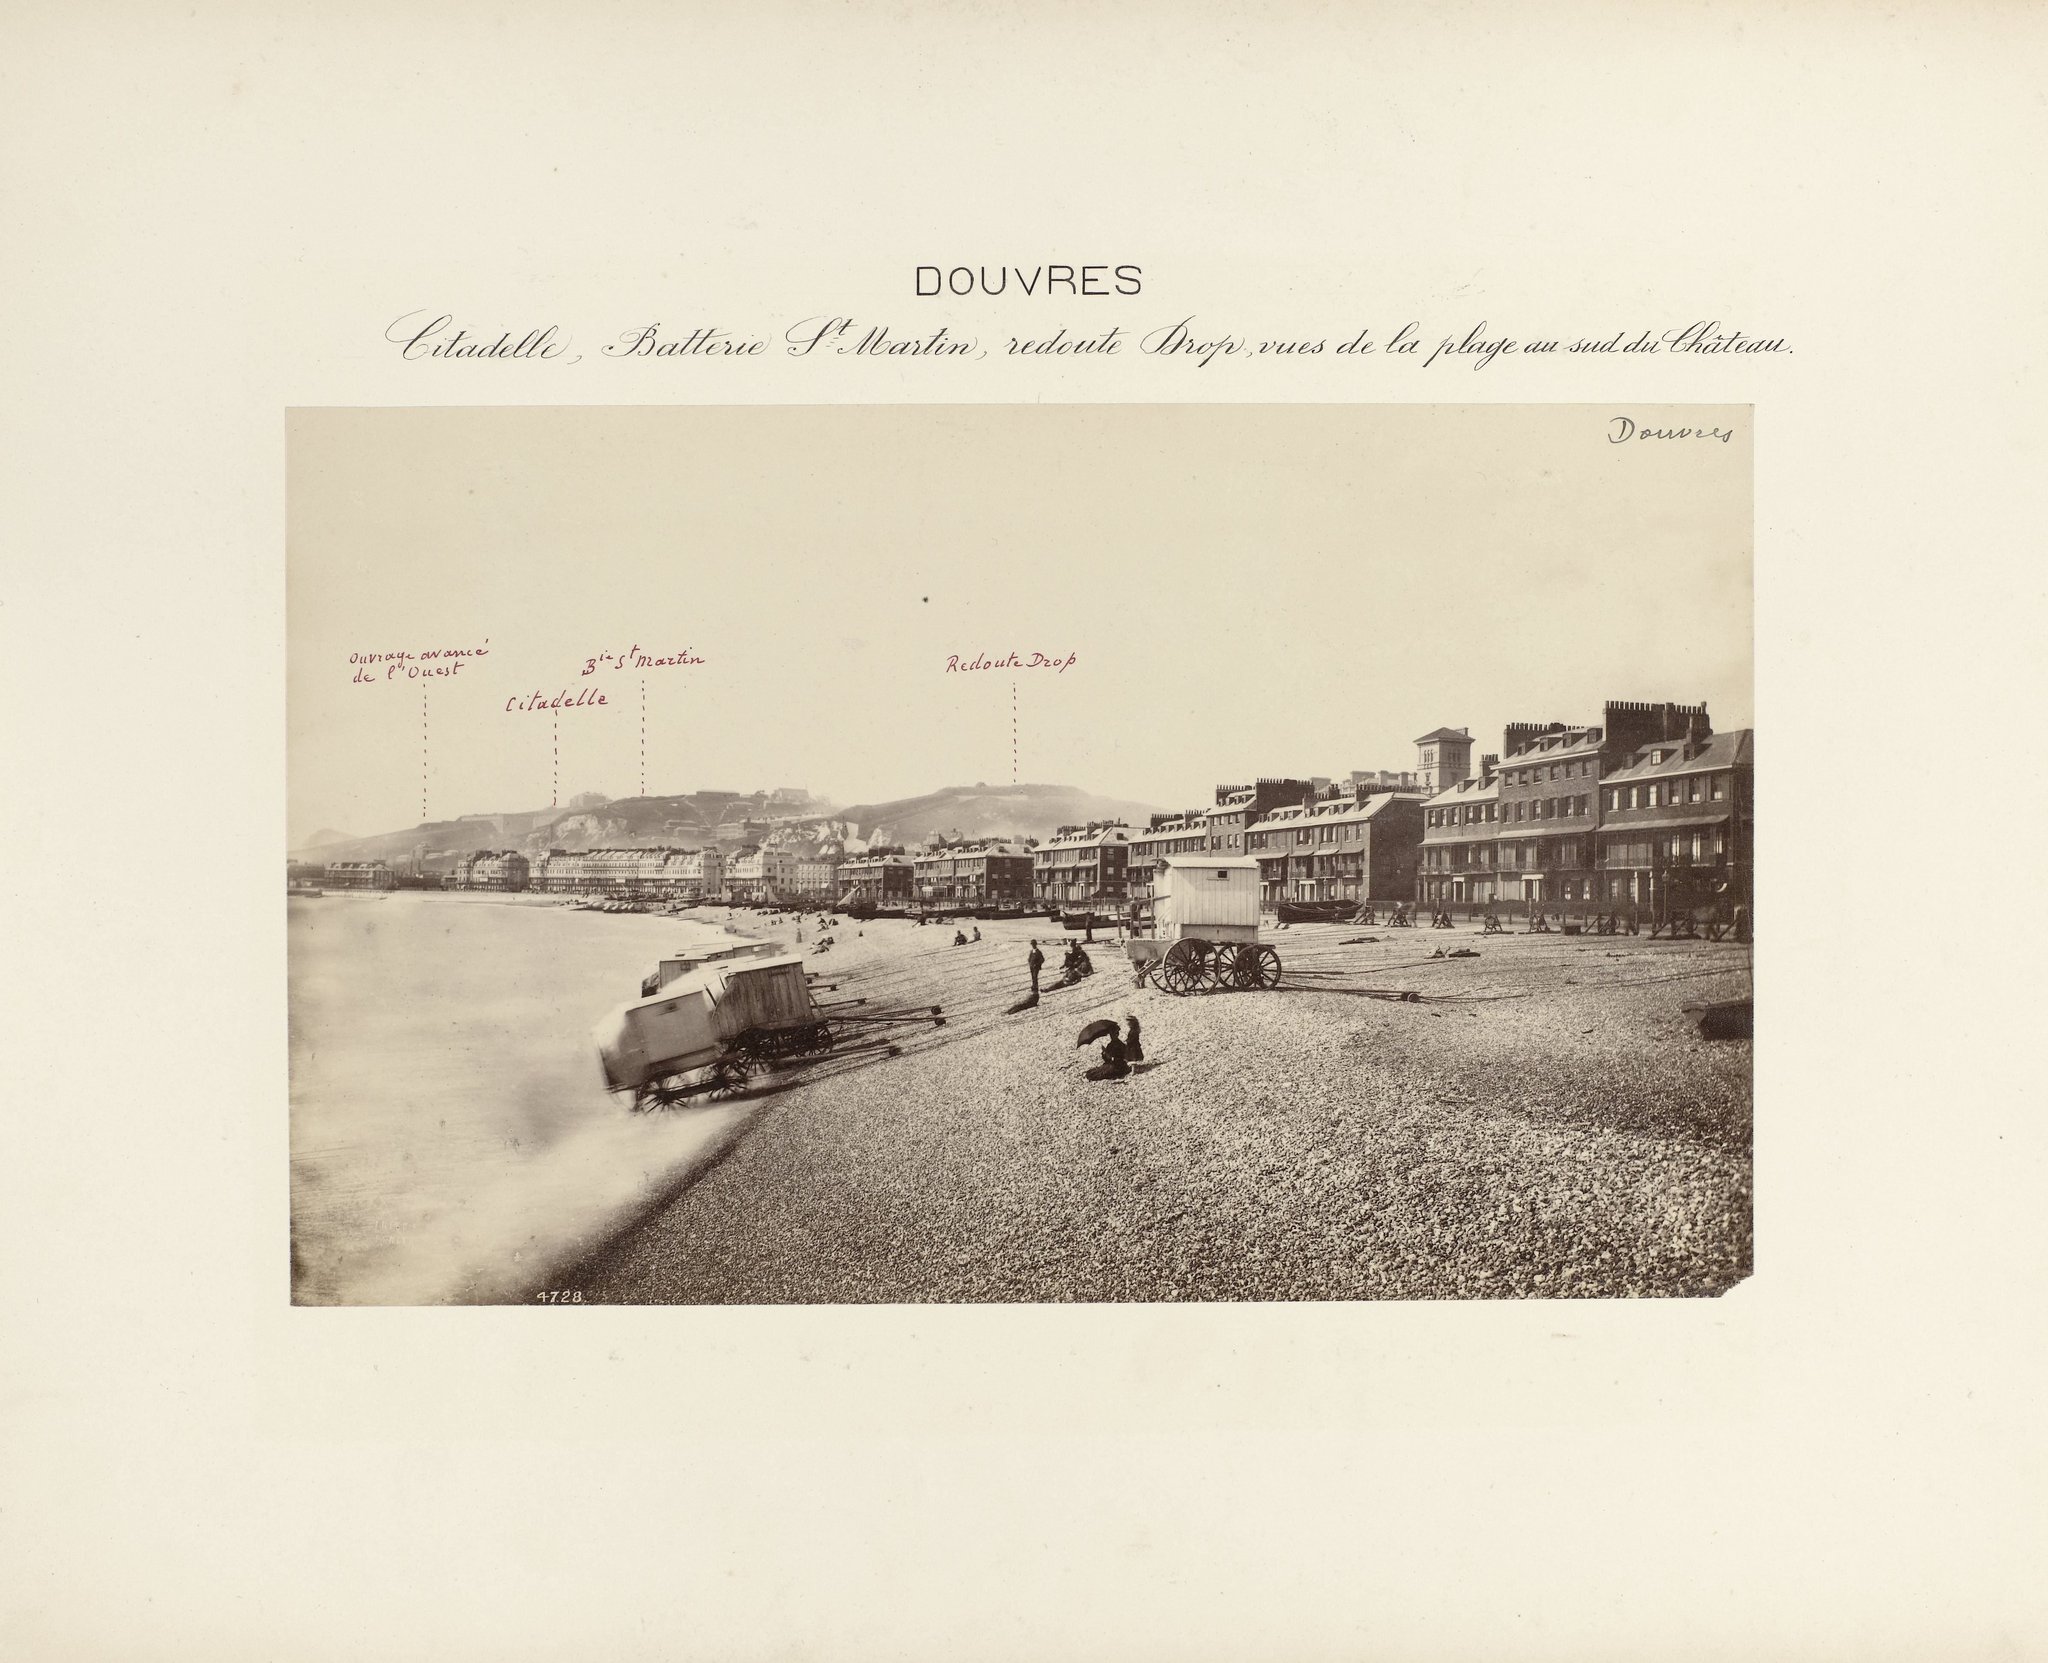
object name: photograph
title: Strand bij Dover, met badkoetsen en badgasten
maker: francis frith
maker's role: publisher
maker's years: 1822-1898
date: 1891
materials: cardboard, paper, photographic support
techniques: albumen print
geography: great britain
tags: dover (engeland)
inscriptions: annotation: ‘ouvrage avancée / de l'ouest // Citadelle // B[atter]ie St Martin // Redoute Drop’, inscription: ‘Douvres’, inscription: ‘DOUVRES / Citadelle, Batterie St Martin, redoute Drop, vues de la plage au sud du Château.’, number: ‘4728’, check stamp: ‘FRITH'S / SERIES’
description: Foto uit een album met 35 topografische foto's van Britse kustplaatsen, waarop in pen militaire verdedigingswerken zijn aangegeven door een Franse militair.